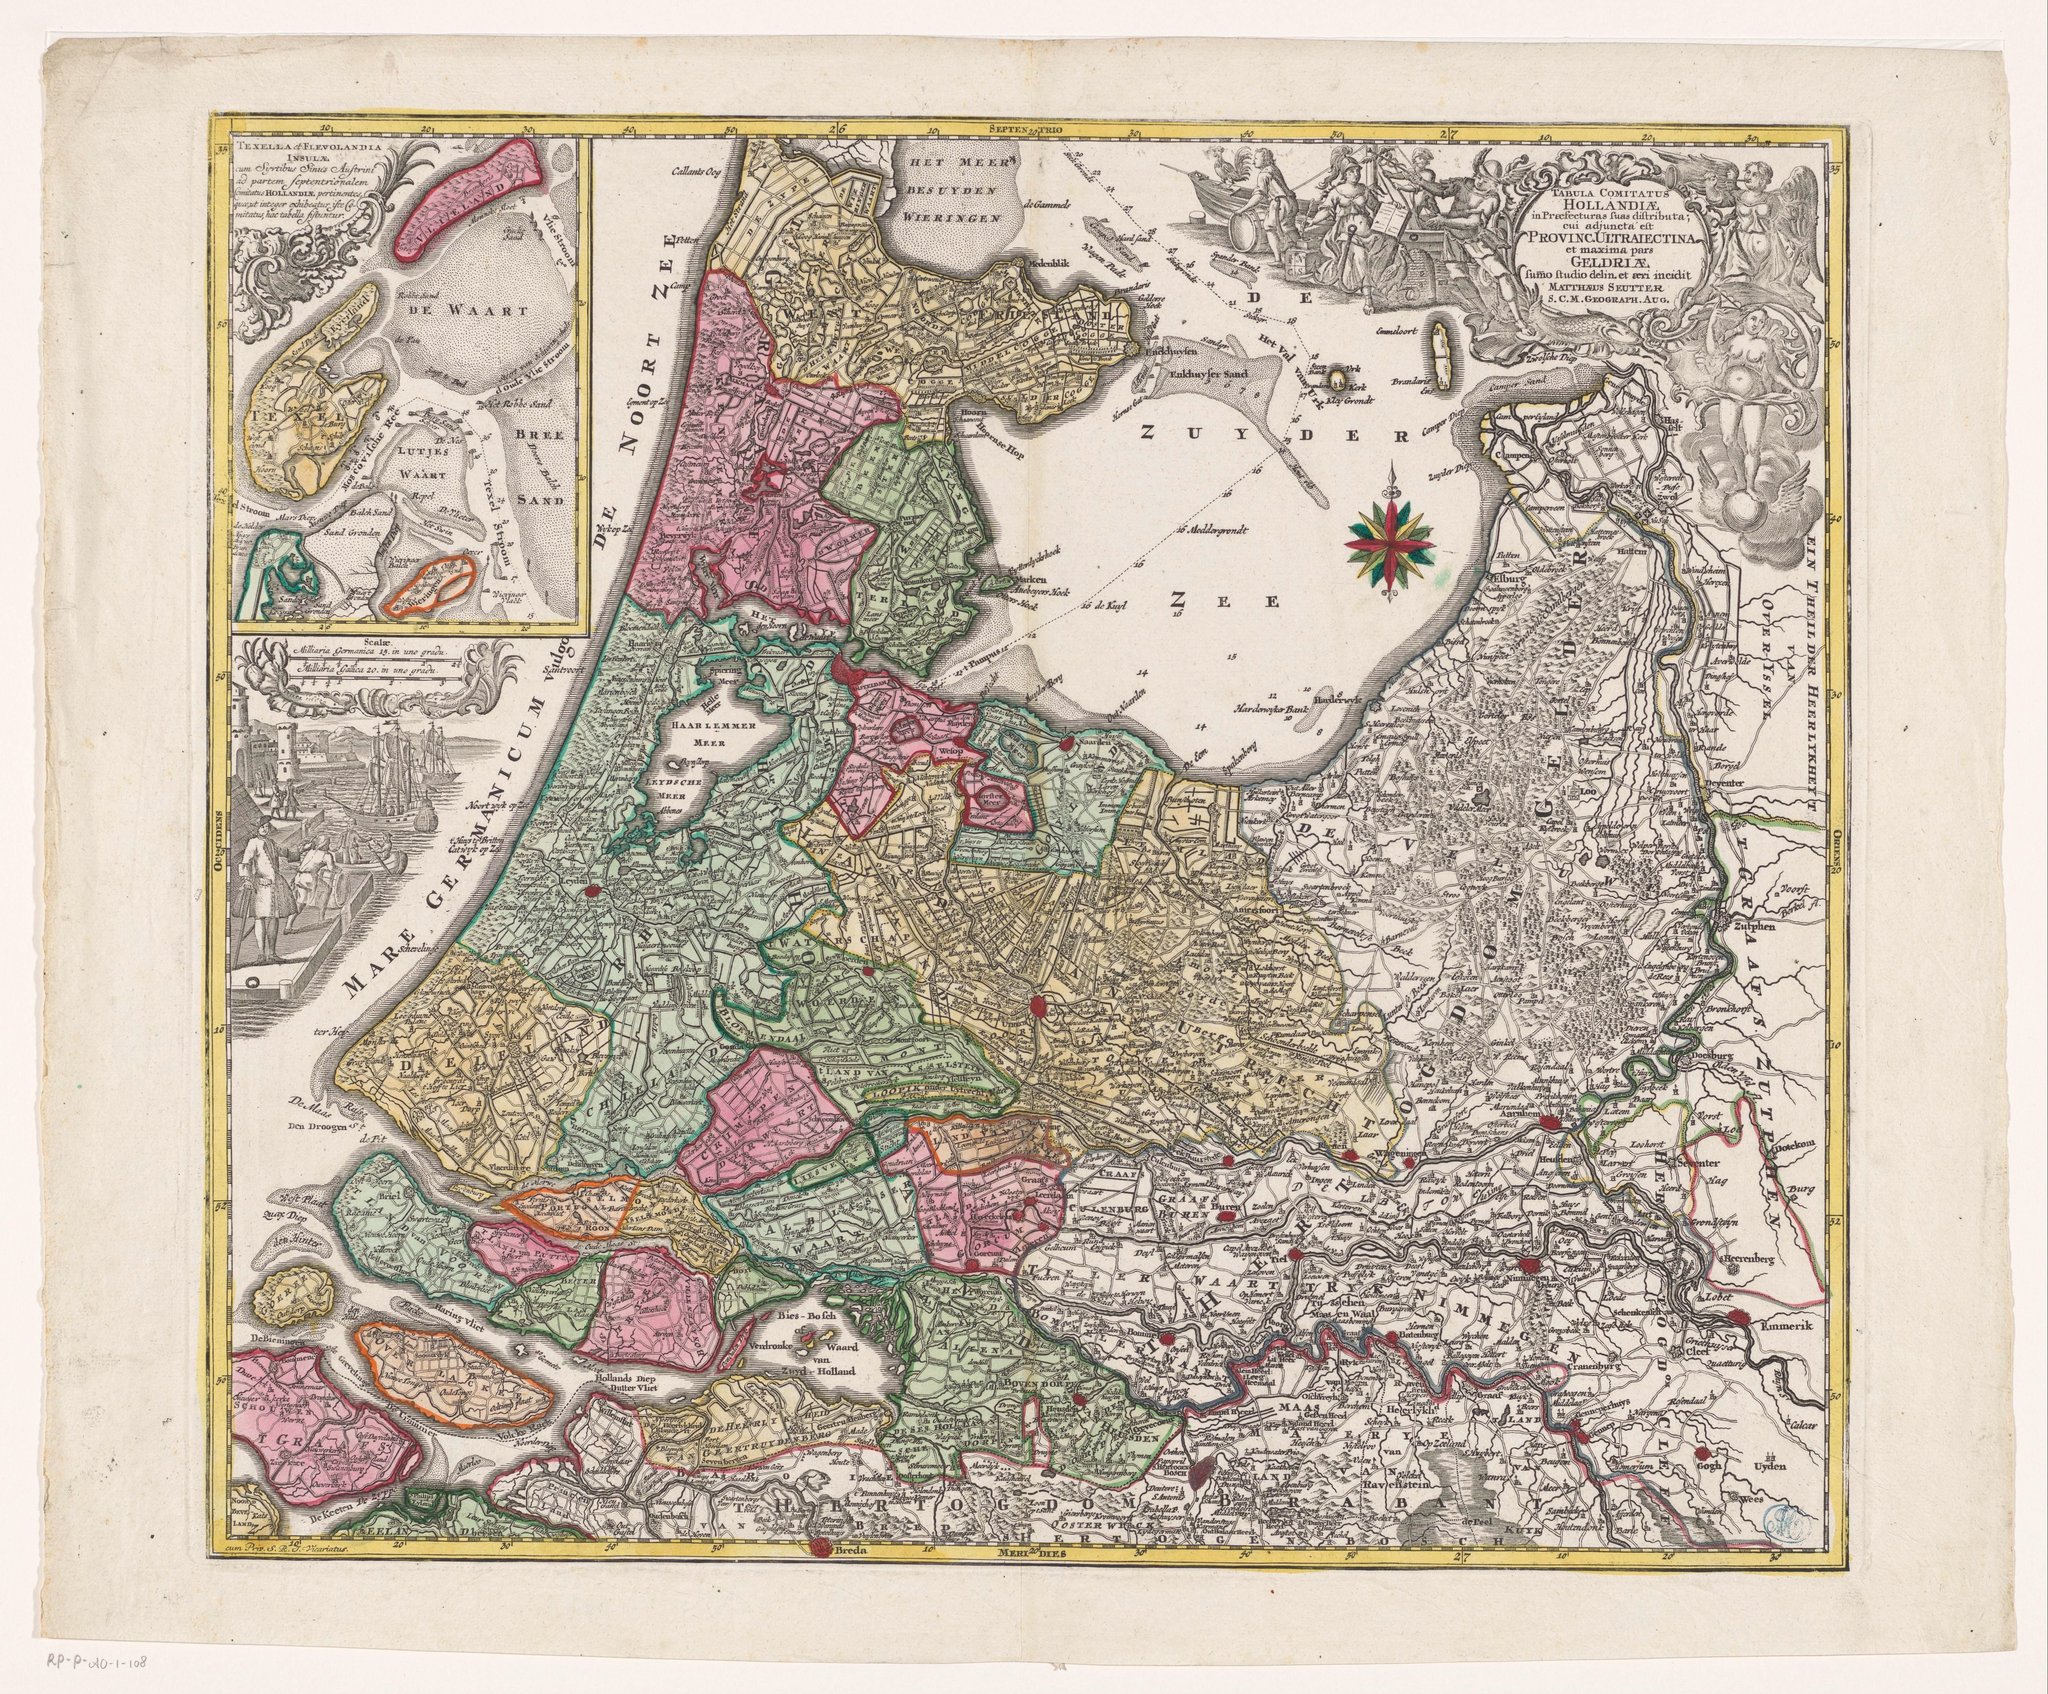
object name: map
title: Kaart van Holland, Utrecht en een deel van Gelderland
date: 1741-1748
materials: paper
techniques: engraving, etching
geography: augsburg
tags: maps of separate countries or regions, (story of) minerva (pallas, athena), (story of) mercury (hermes), merchant shipping, shipping trade, gelderland, holland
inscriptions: collector's mark: Lugt 195, collector's mark: Lugt 2228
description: Links inzetkaart van de Kop van Noord-Holland, Texel en Vlieland. Daaronder twee schaalstokken: Milliaria Germanica 15 in uno gradu, Milliaria Gallica 20 in uno gradu. Daaronder een havengezicht met een aantal zeelui, burgers en schepen. Rechts titelcartouche met daaromheen een aantal figuren: zeelui, Minerva, Mercurius, Fama en een naakte vrouw op een gevleugelde bol. Gradenverdeling langs de randen.